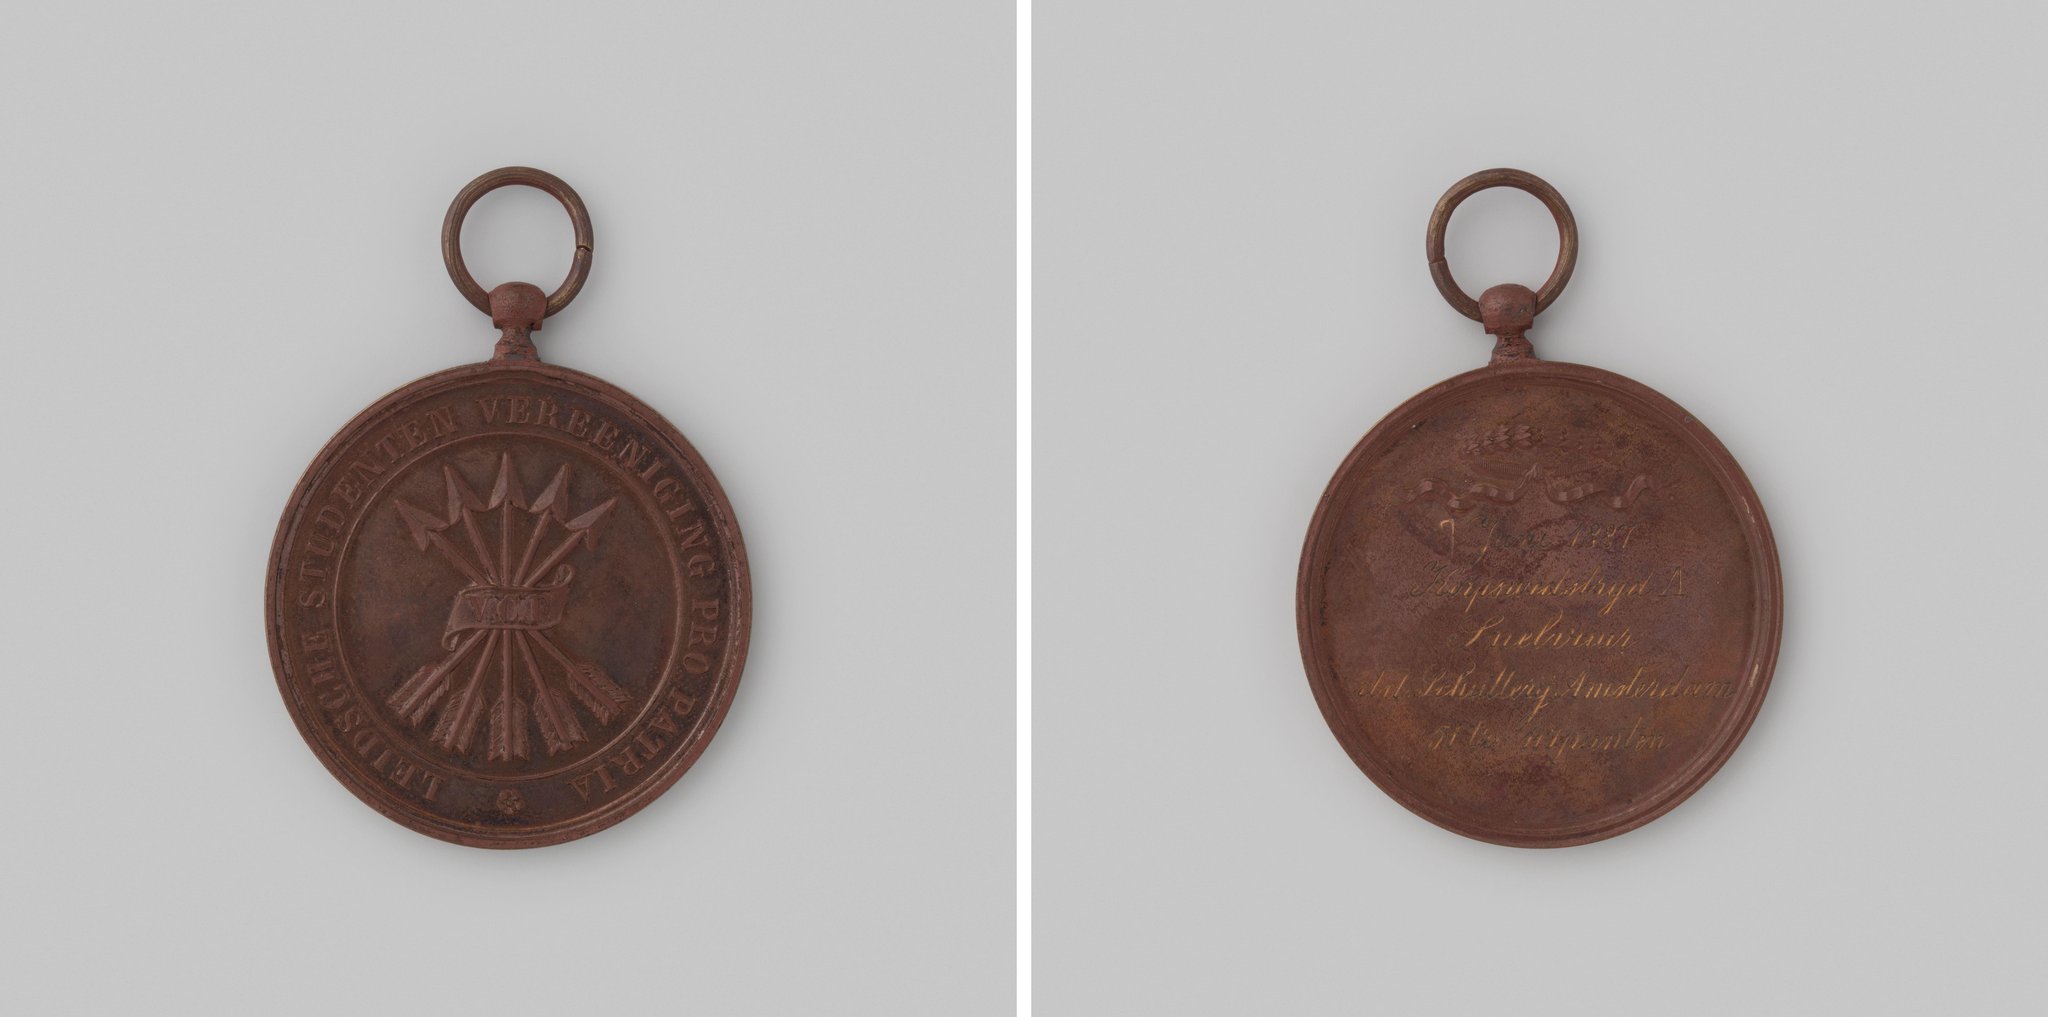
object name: medal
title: Prijspenning voor snelvuur, van de Leidsche Studenten Vereeniging 'Pro Patria'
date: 1887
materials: bronze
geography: leiden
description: Bronzen penning. Voorzijde: wapen van het Leidse Studentenkorps, bundel met vijf pijlen (de vijf faculteiten) waarop een banderol met de letters V. (virtus) C. (concordia) F. (fides). Omschrift: LEIDSCHE STUDENTEN VEREENIGING PRO PATRIA. Keerzijde: een lauwerkransje met twee wapperende linten, waaronder gegraveerd: Juni 1887 / Korpswedstrijd A / Snelvuur / dd Schutterij Amsterdam / 51 tr 117. Prijspenning behaald op 14 juni 1887 door de schutterij van Amsterdam in een schietwedstrijd uitgeschreven door de Leidsche ''Studentenvereeniging tot vrijwillige oefening in den wapenhandel Pro Patria''